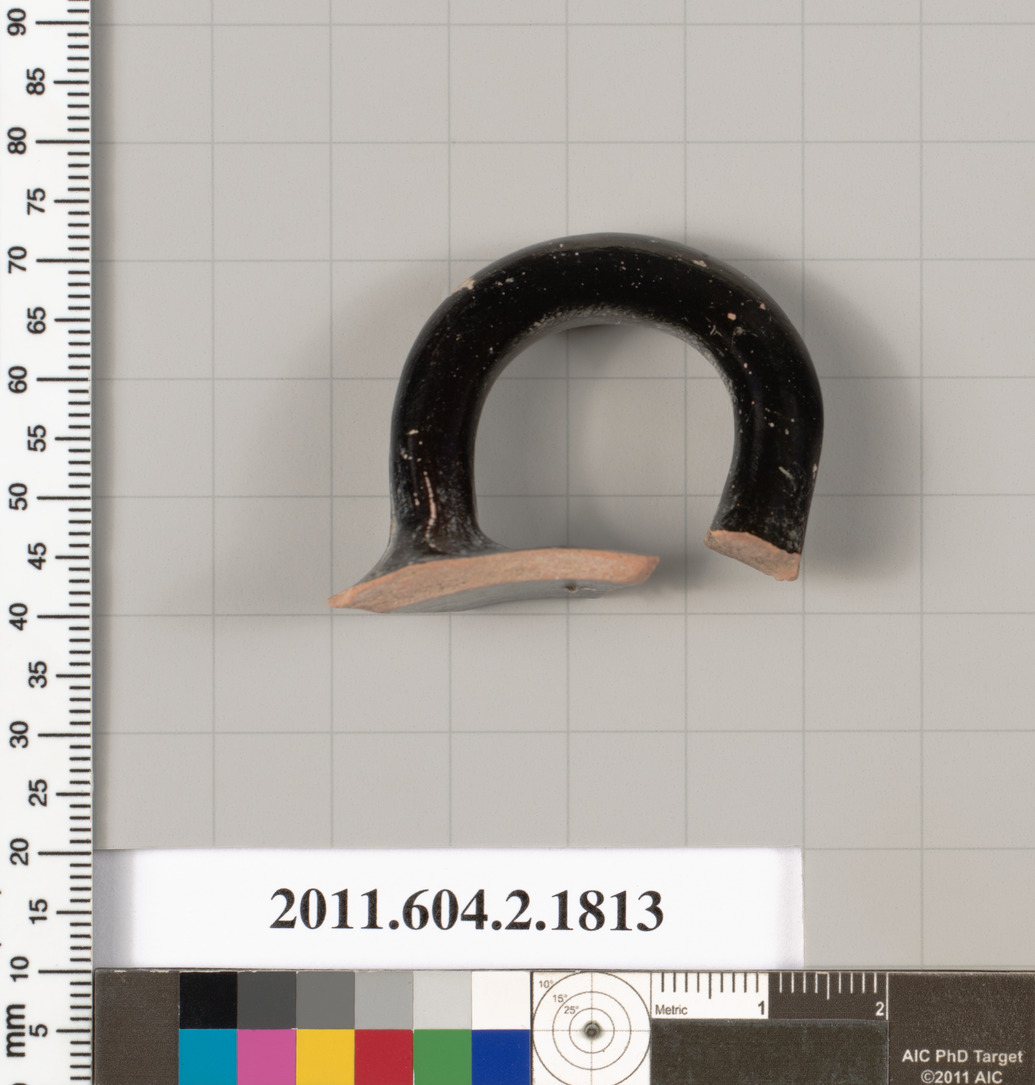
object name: skyphos fragment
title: Terracotta fragment of a skyphos (deep drinking cup)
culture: greek, attic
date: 500-401 BCE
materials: terracotta